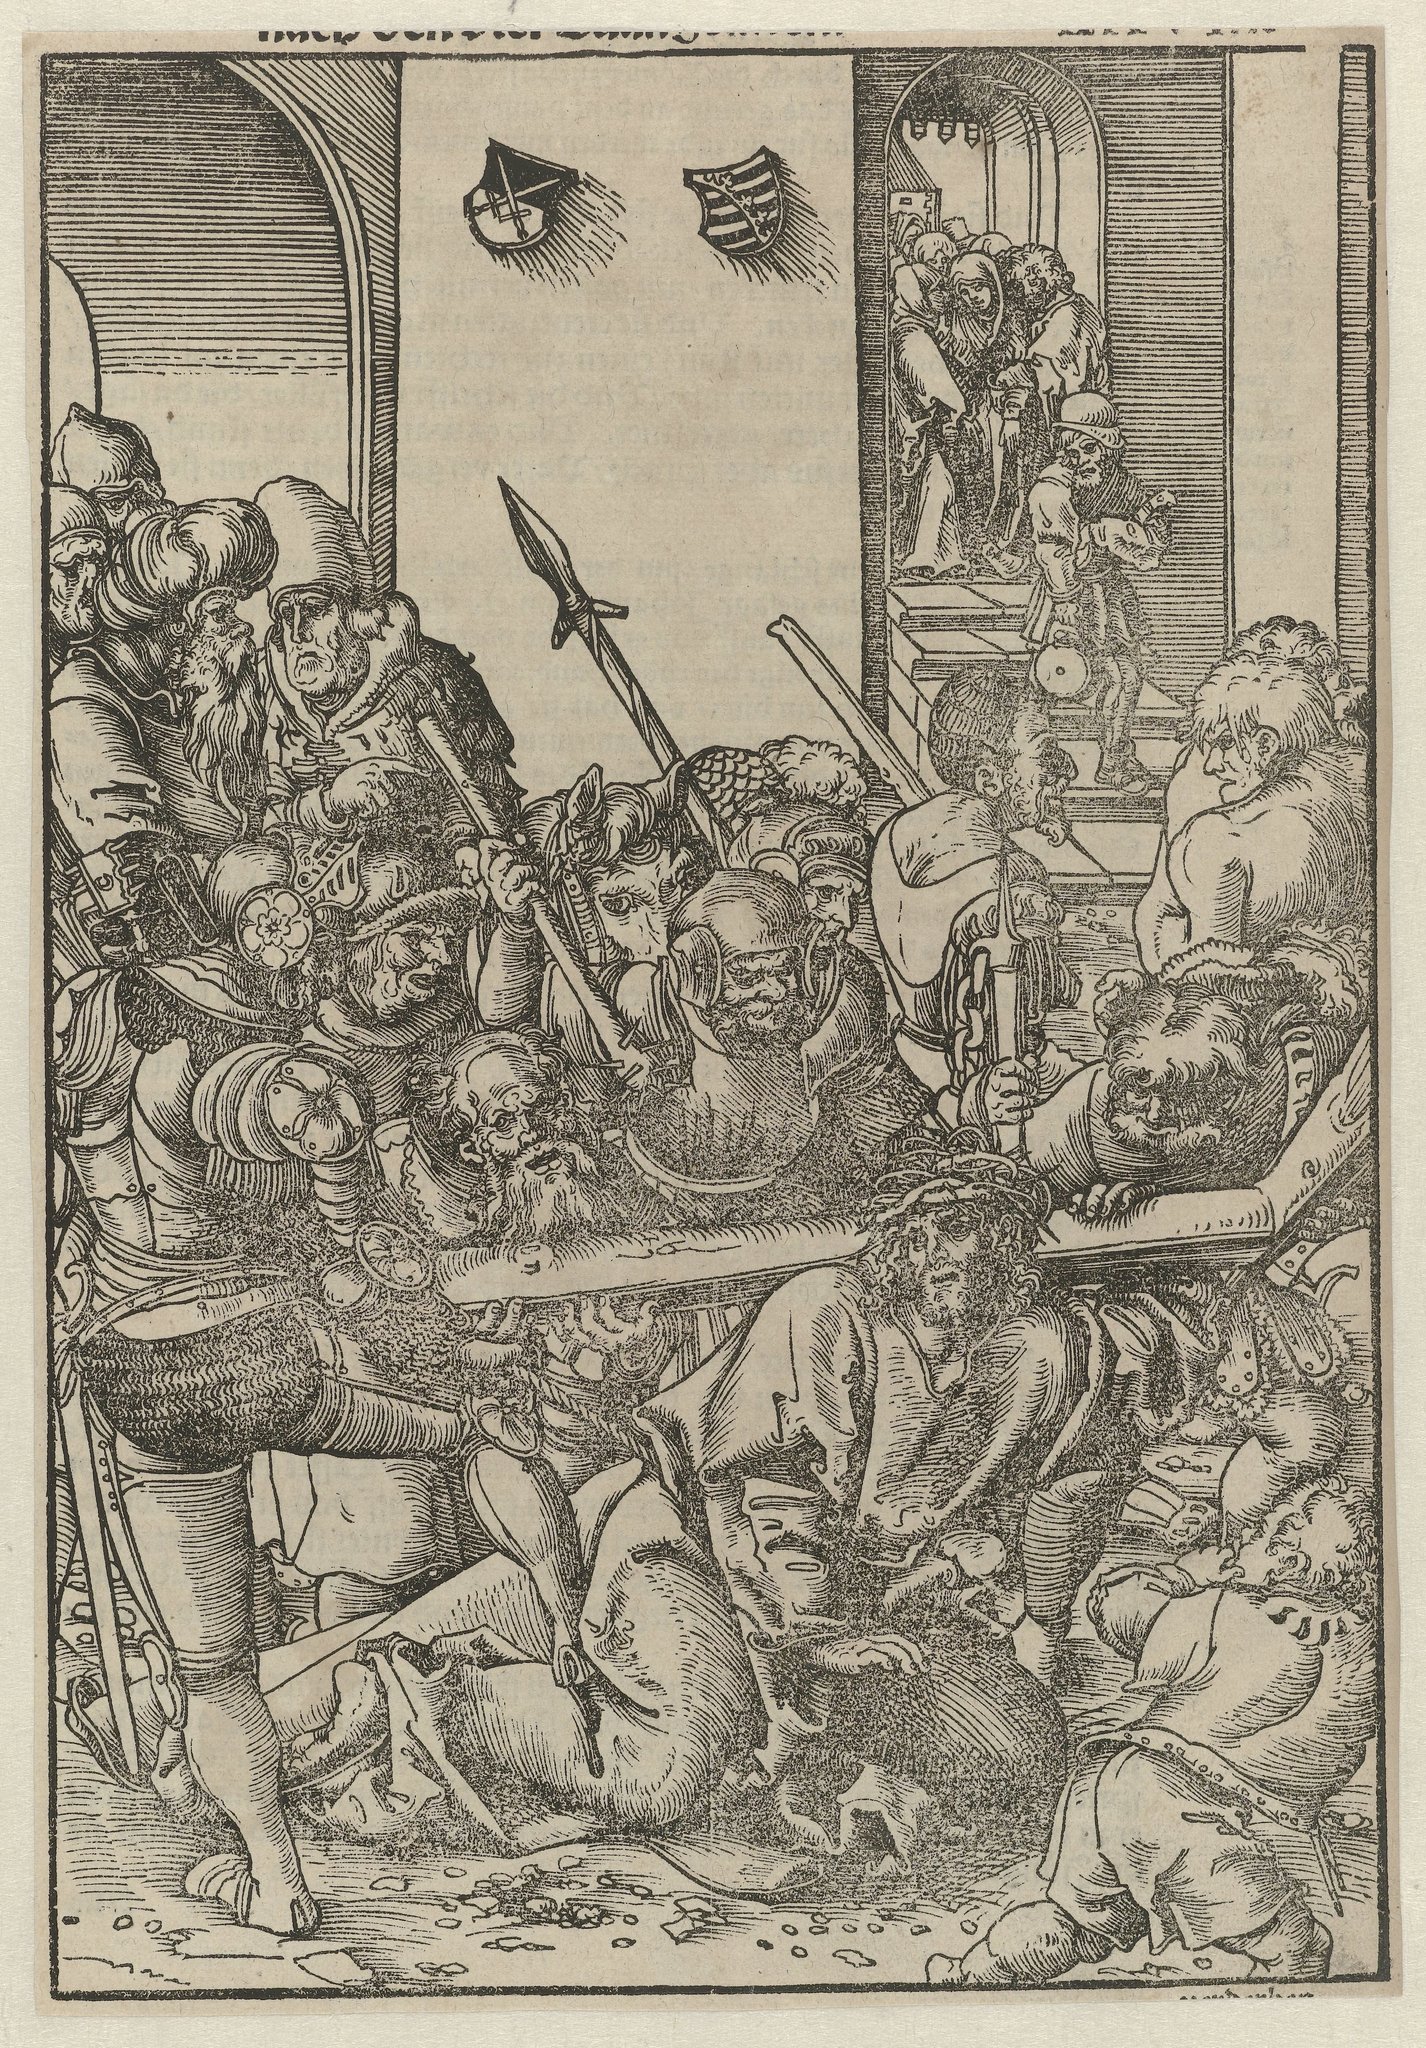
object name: print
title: De kruisdraging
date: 1540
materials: paper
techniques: woodcut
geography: wittenberg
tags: carrying of the cross: christ bearing the cross, alone or with the help of others (e.g. simon the cyrenian)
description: Tiende prent uit een serie van veertien met de passie, gebruikt in het Passional Buch. In het midden op de voorgrond omringd door soldaten bezwijkt Christus onder het gewicht van het kruis. Een soldaat links trapt hem. Simon van Cyrene pakt het kruis vast. Op de achtergrond rechts staat Maria temidden van mannelijke en vrouwelijke volgelingen. Bovenaan in het midden twee wapenschilden.